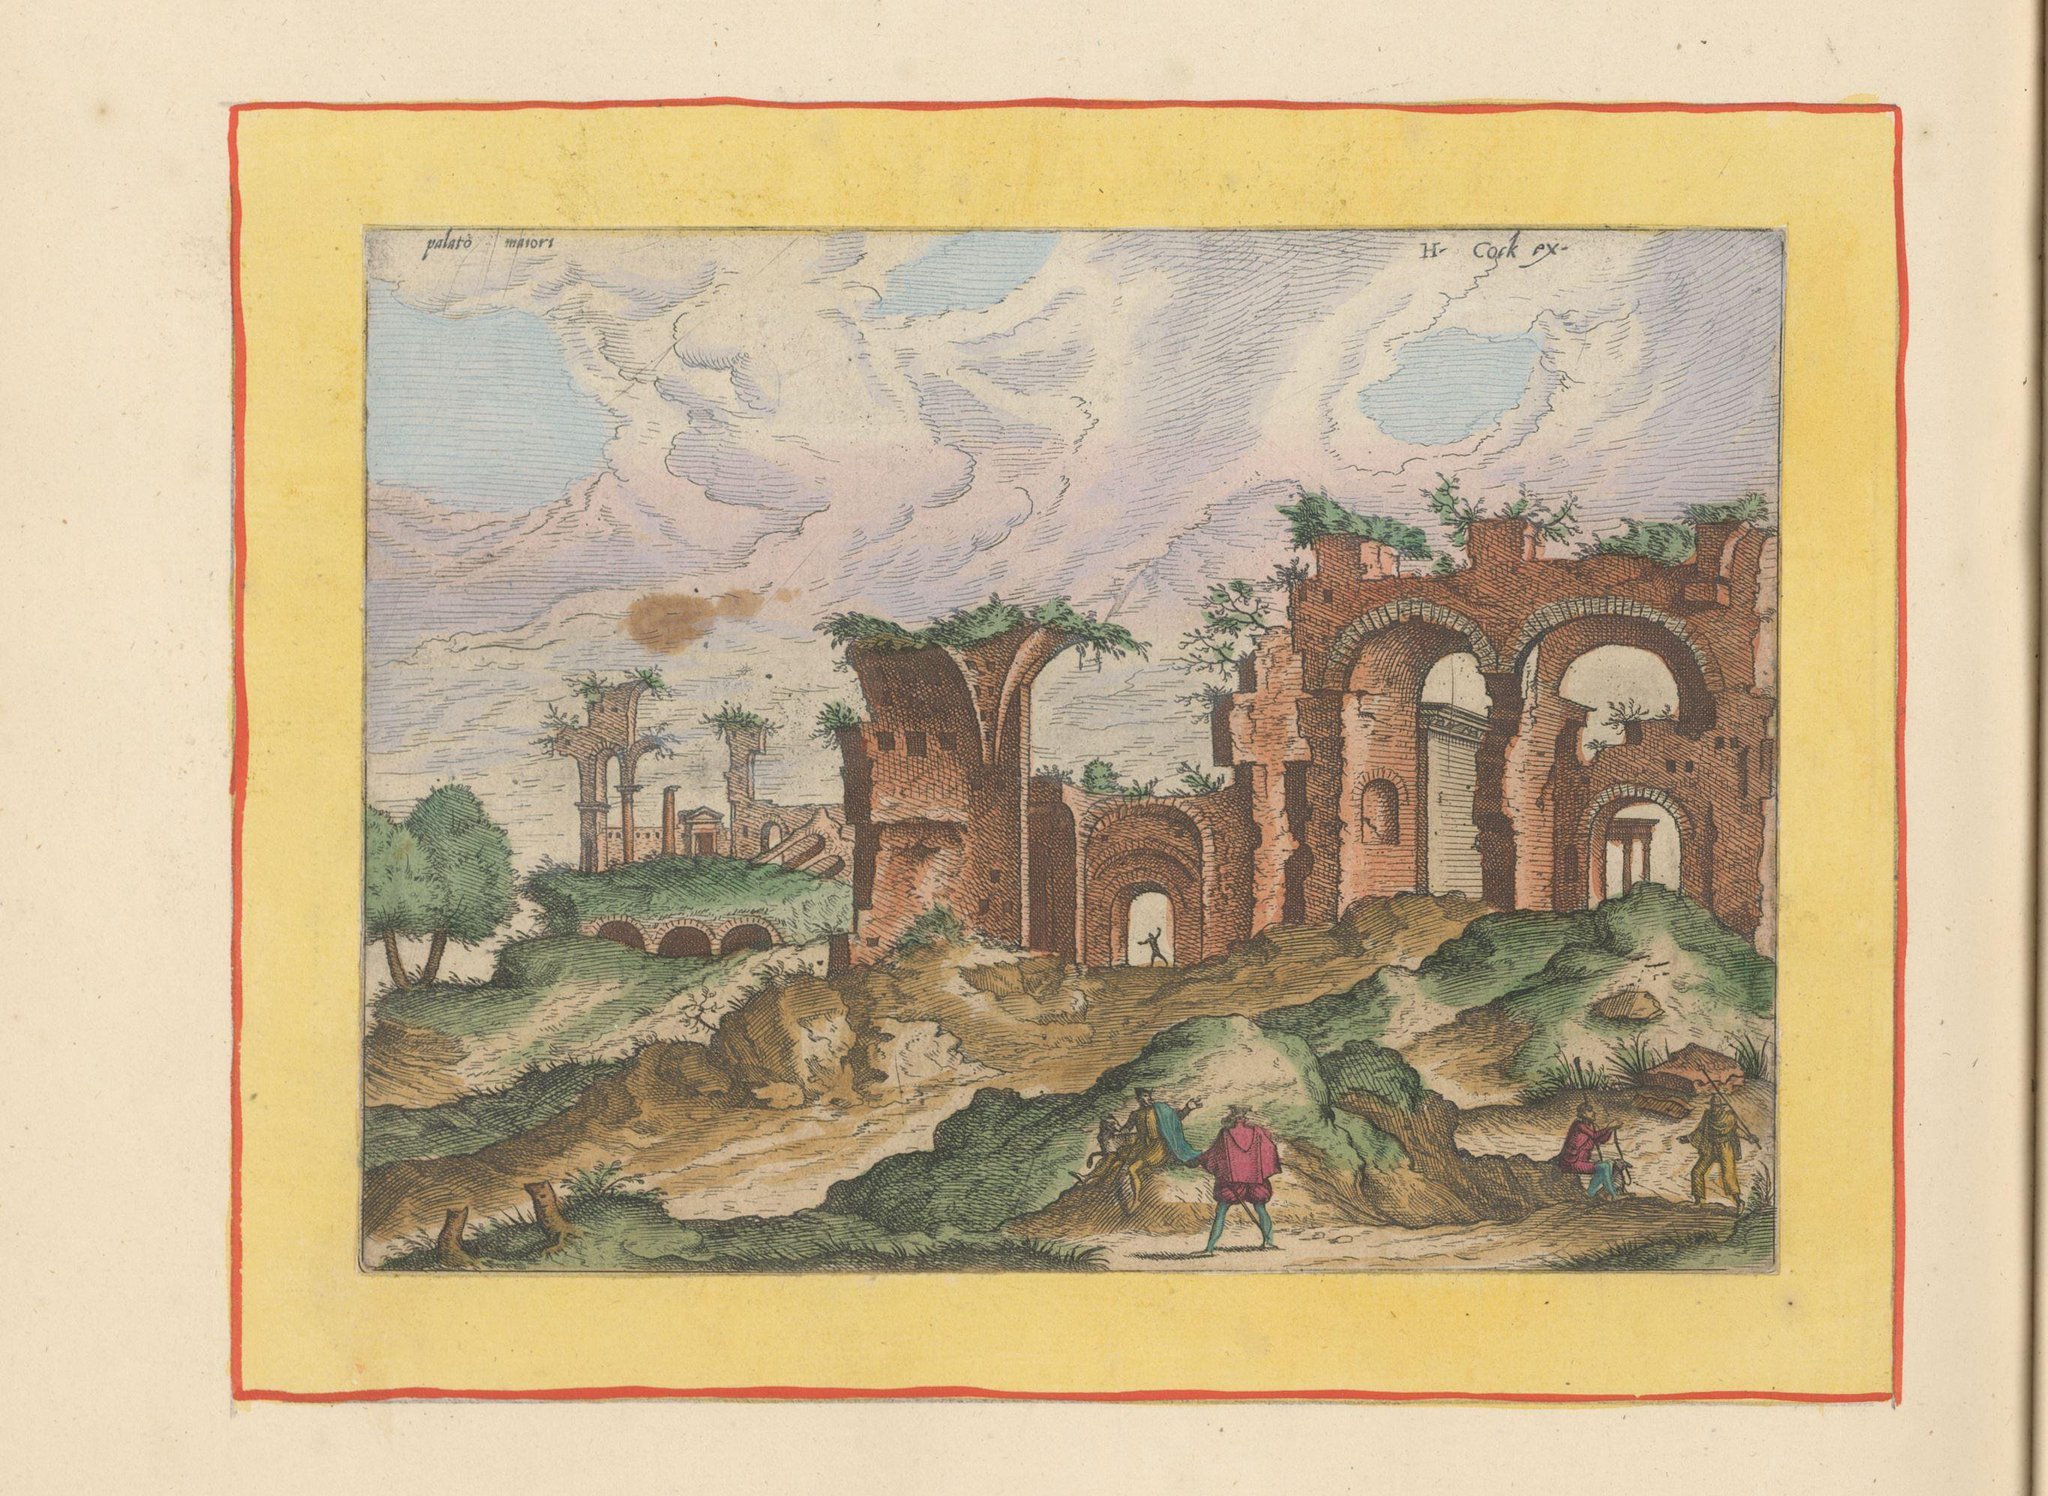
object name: album leaf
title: Romeinse ruïnes en gebouwen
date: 1562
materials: paper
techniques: colour, etching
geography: antwerp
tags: ruin of a building ~ architecture, landscape with ruins, rome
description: Gezicht op de ruïnes op de Palatijn te Rome. Op de voorgrond zitten rustende figuren. Prent maakt deel uit van een album.